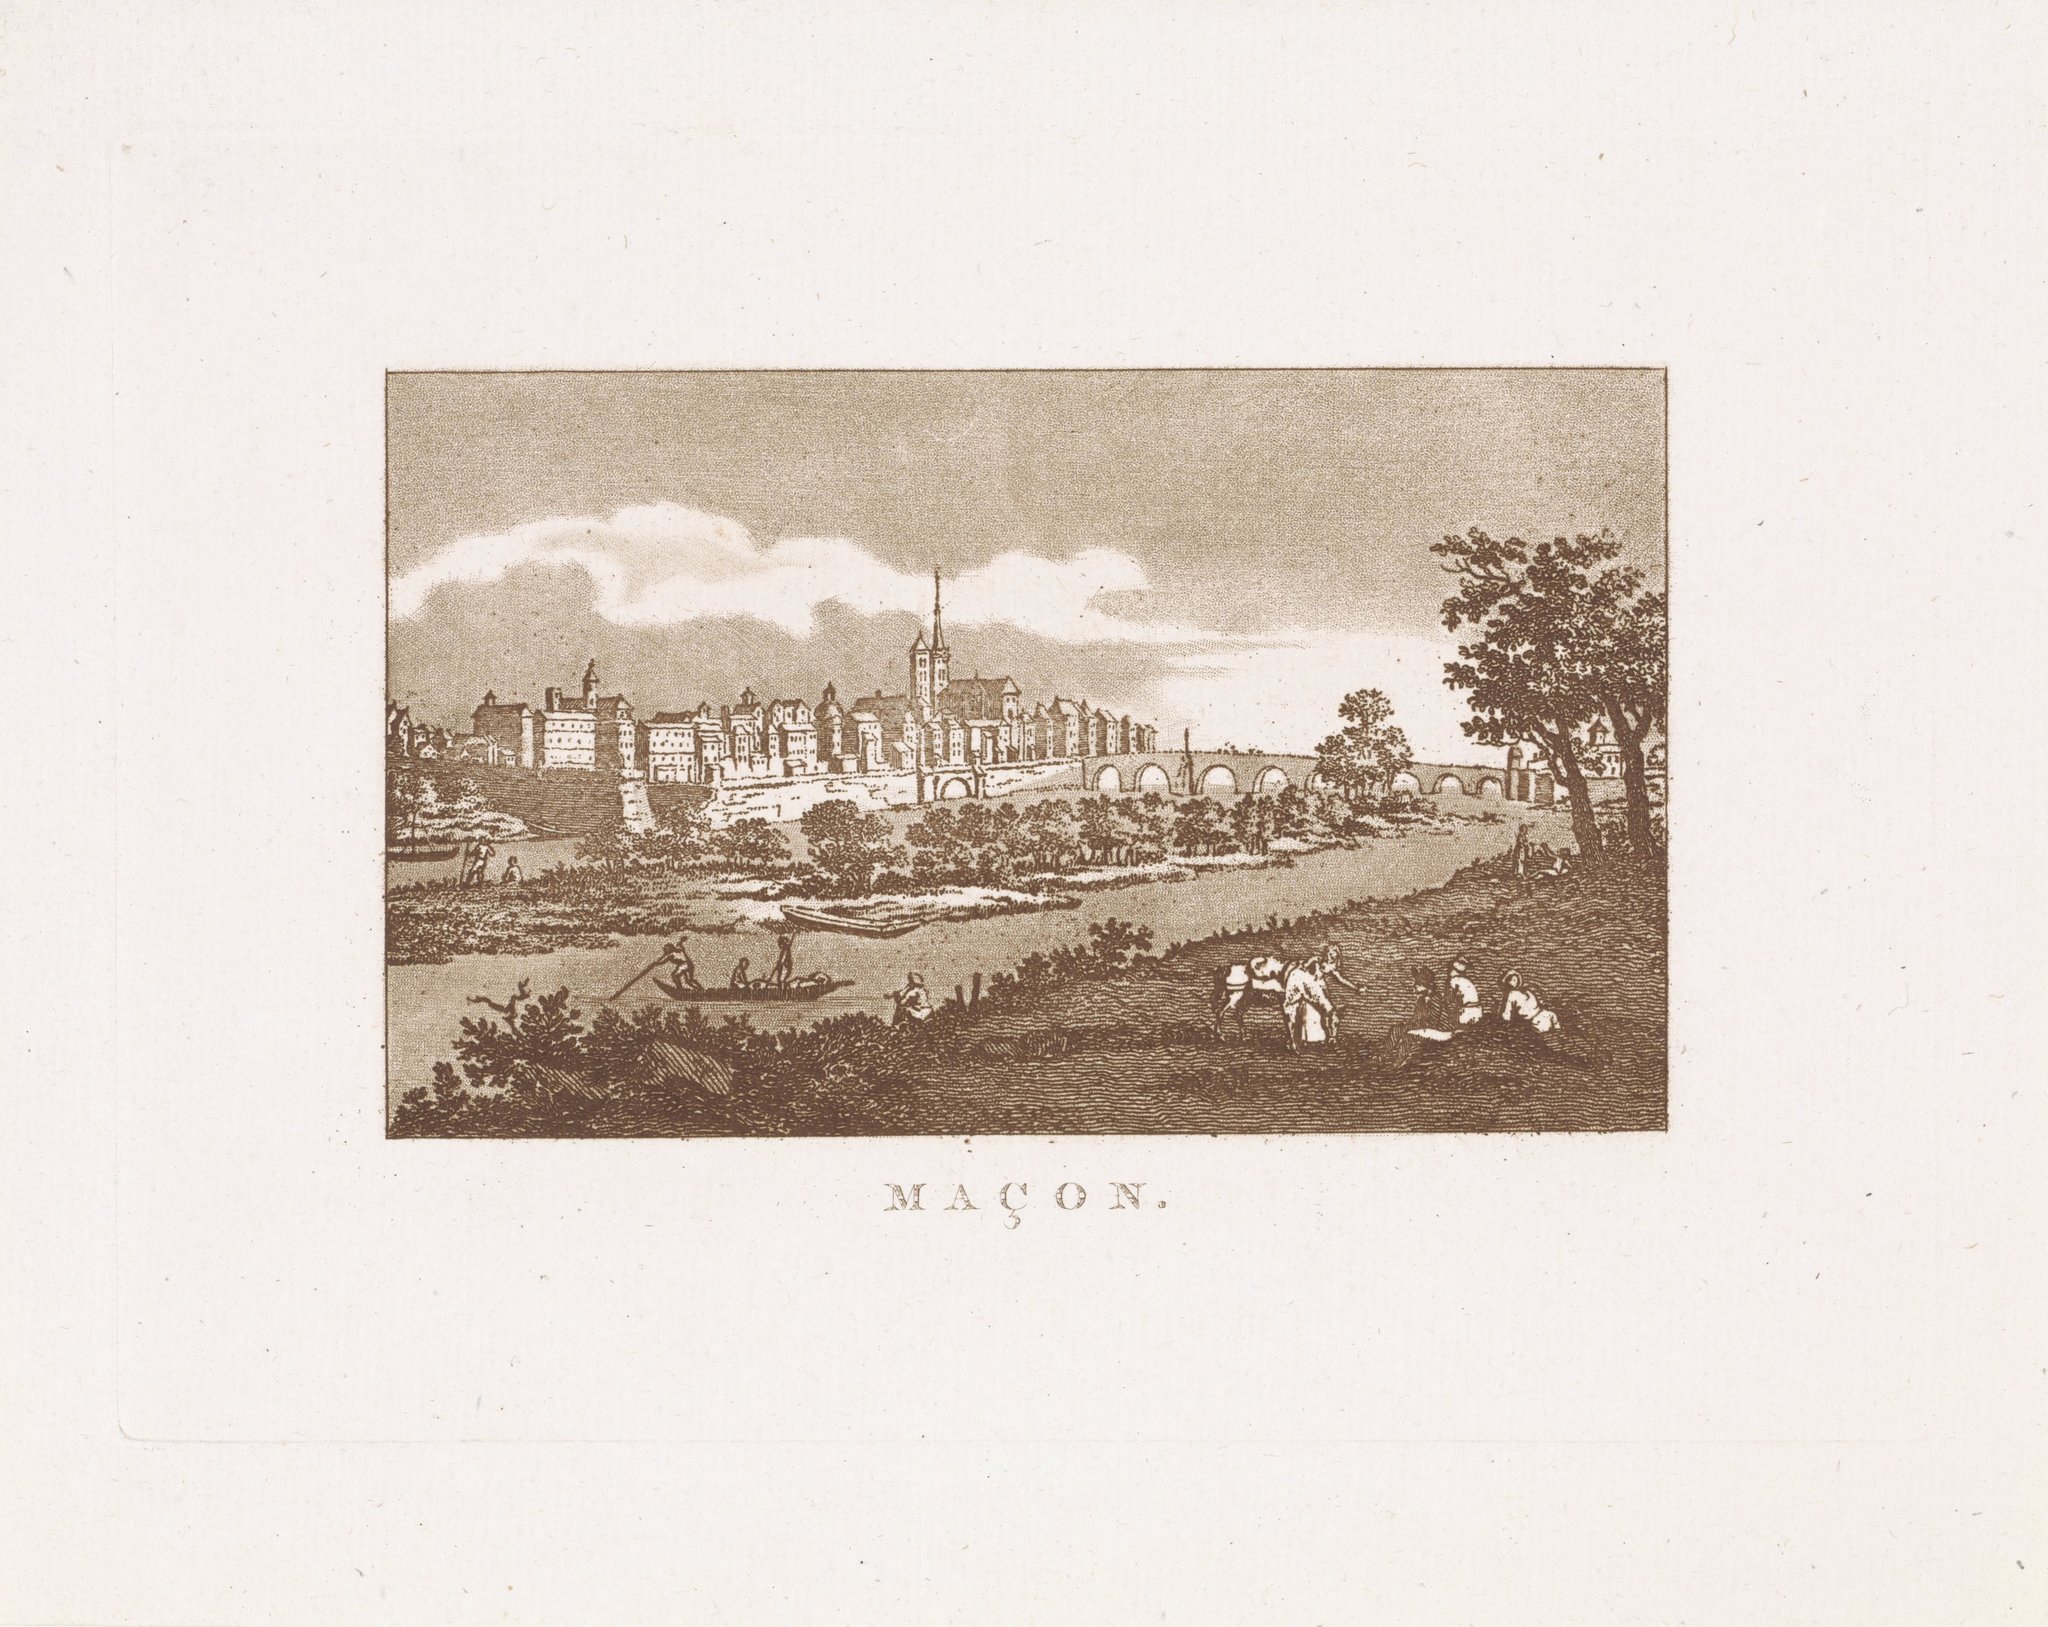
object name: print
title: Gezicht op Mâcon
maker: daniël veelwaard (i)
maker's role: print maker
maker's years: 1766-1851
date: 1776-1851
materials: paper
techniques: etching, roulette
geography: amsterdam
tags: landscape with bridge, viaduct or aqueduct, prospect of city, town panorama, silhouette of city (+ city(-scape) with figures, staffage)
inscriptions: collector's mark: Lugt 2228